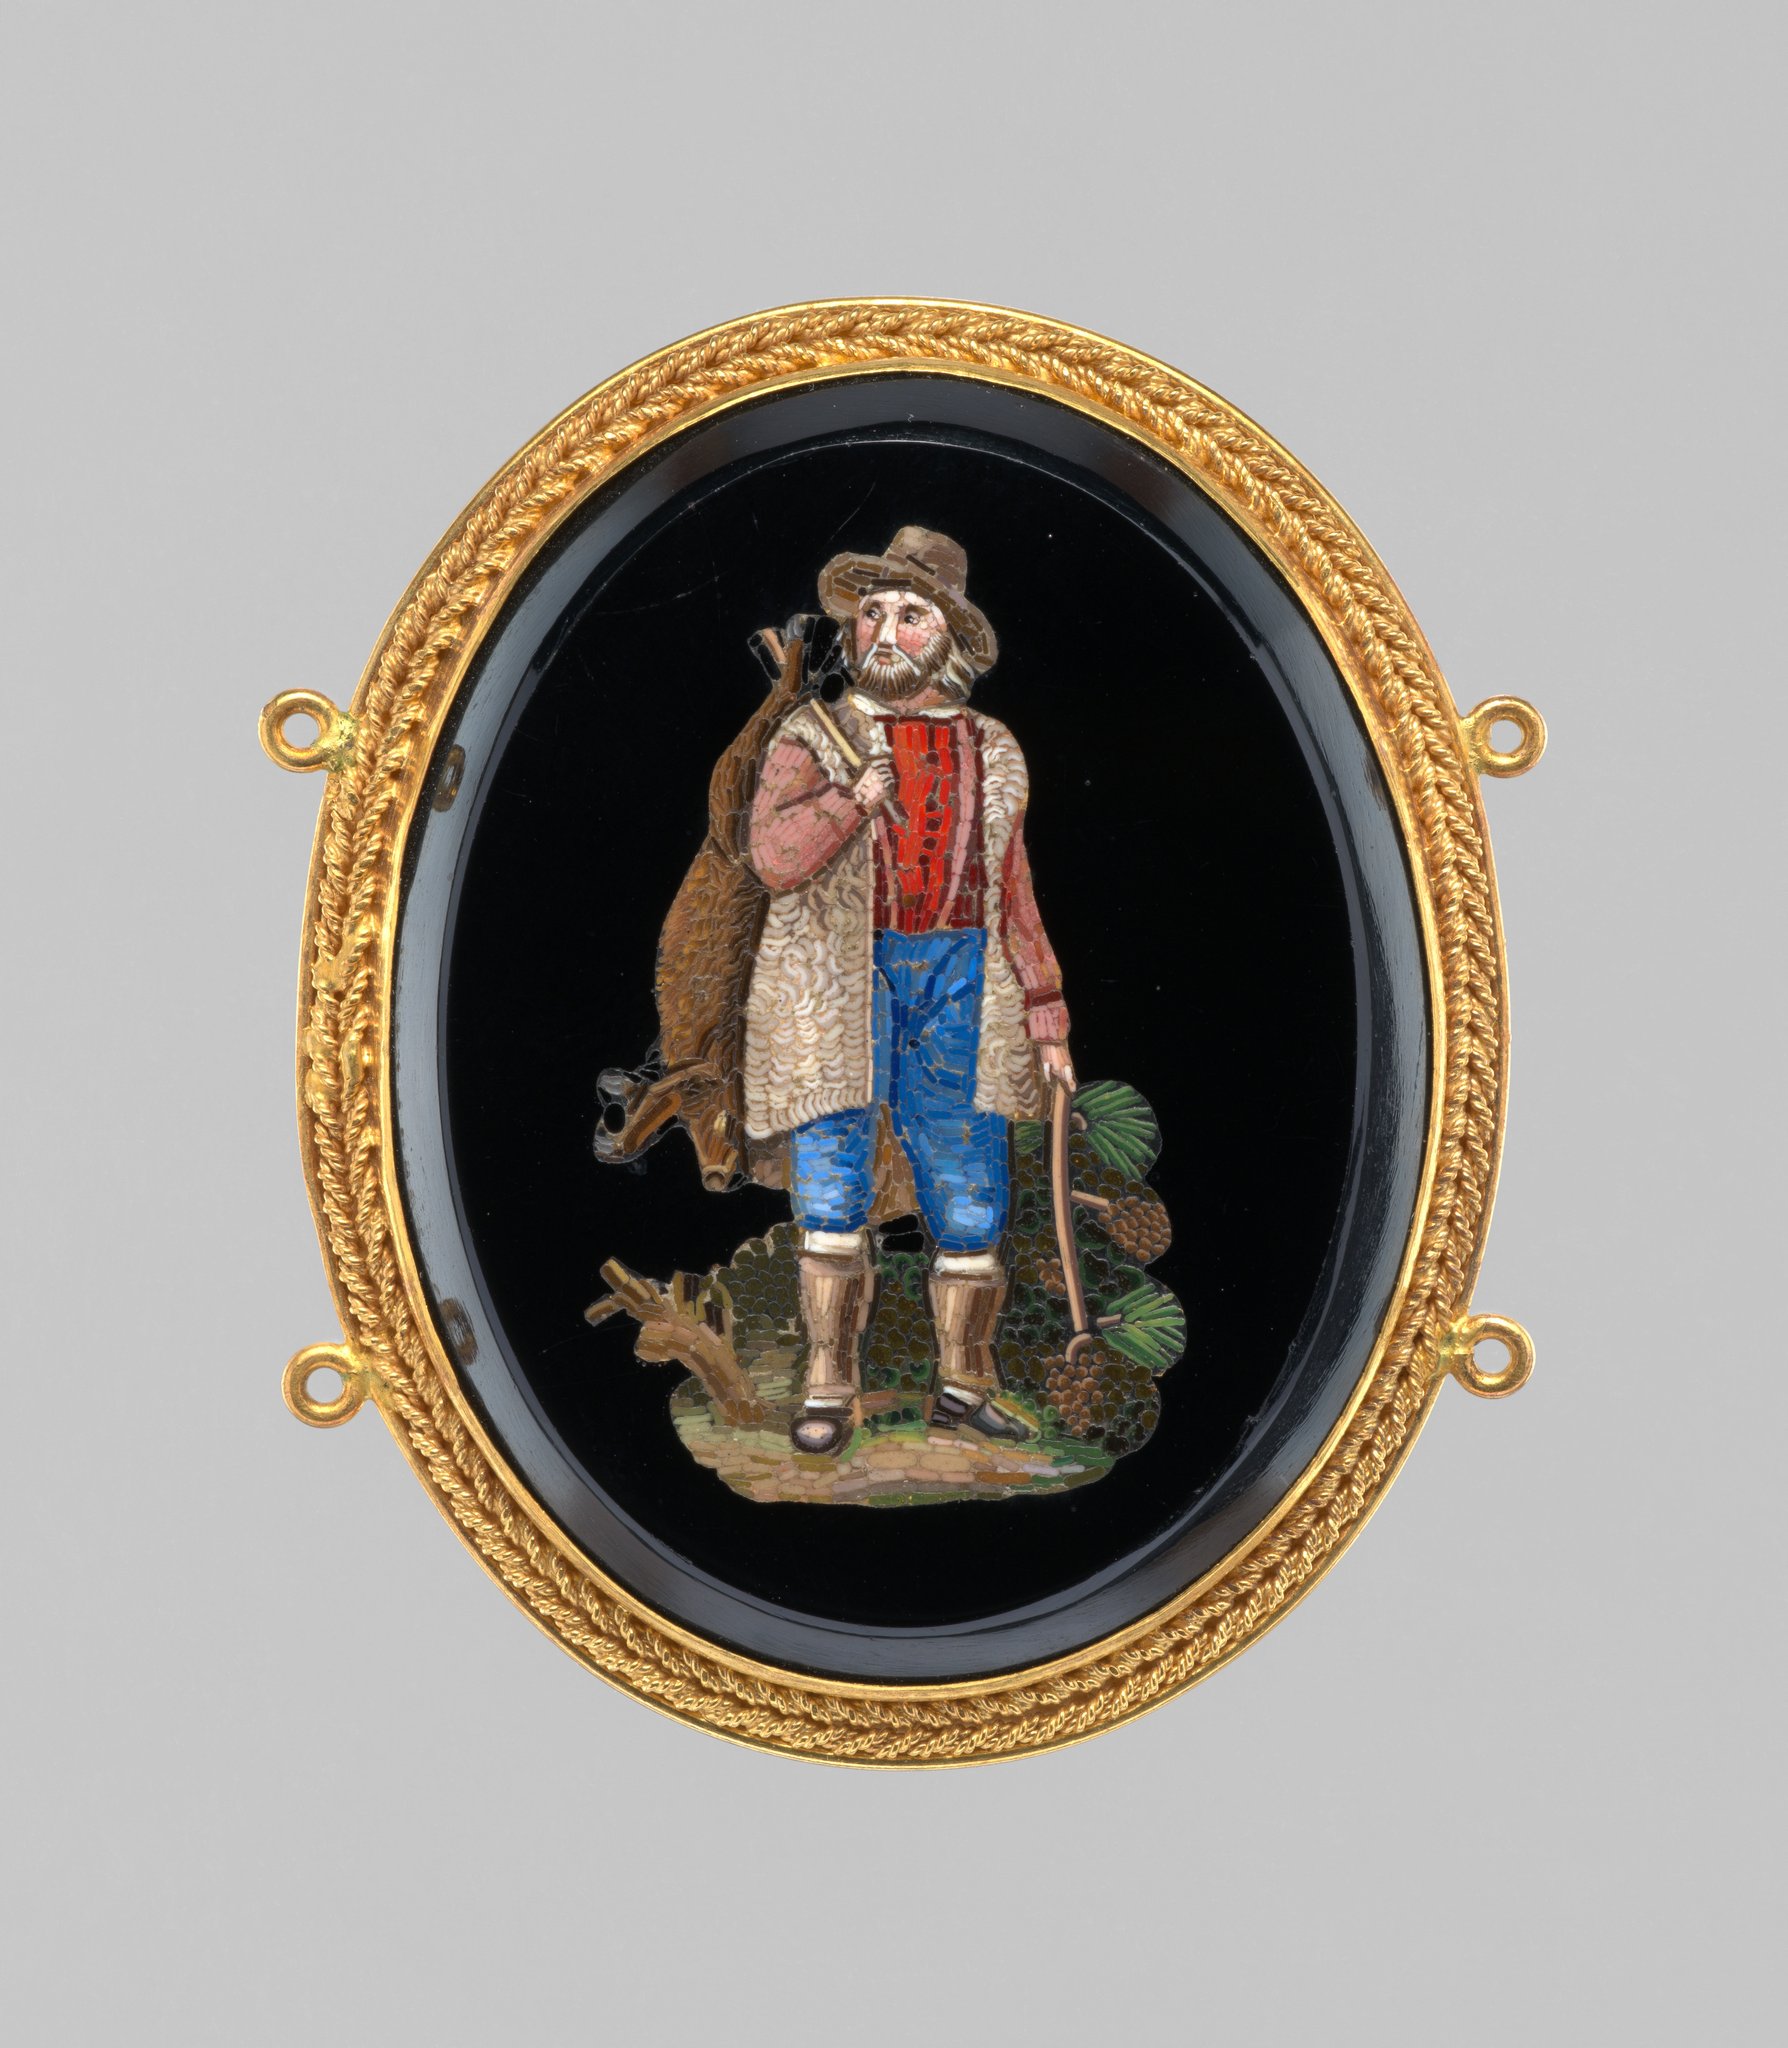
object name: medallion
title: Medallion (part of a set)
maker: g.l. barberi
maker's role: maker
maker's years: 1800-1900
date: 1801-1900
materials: glass, gold, onyx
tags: animals,men